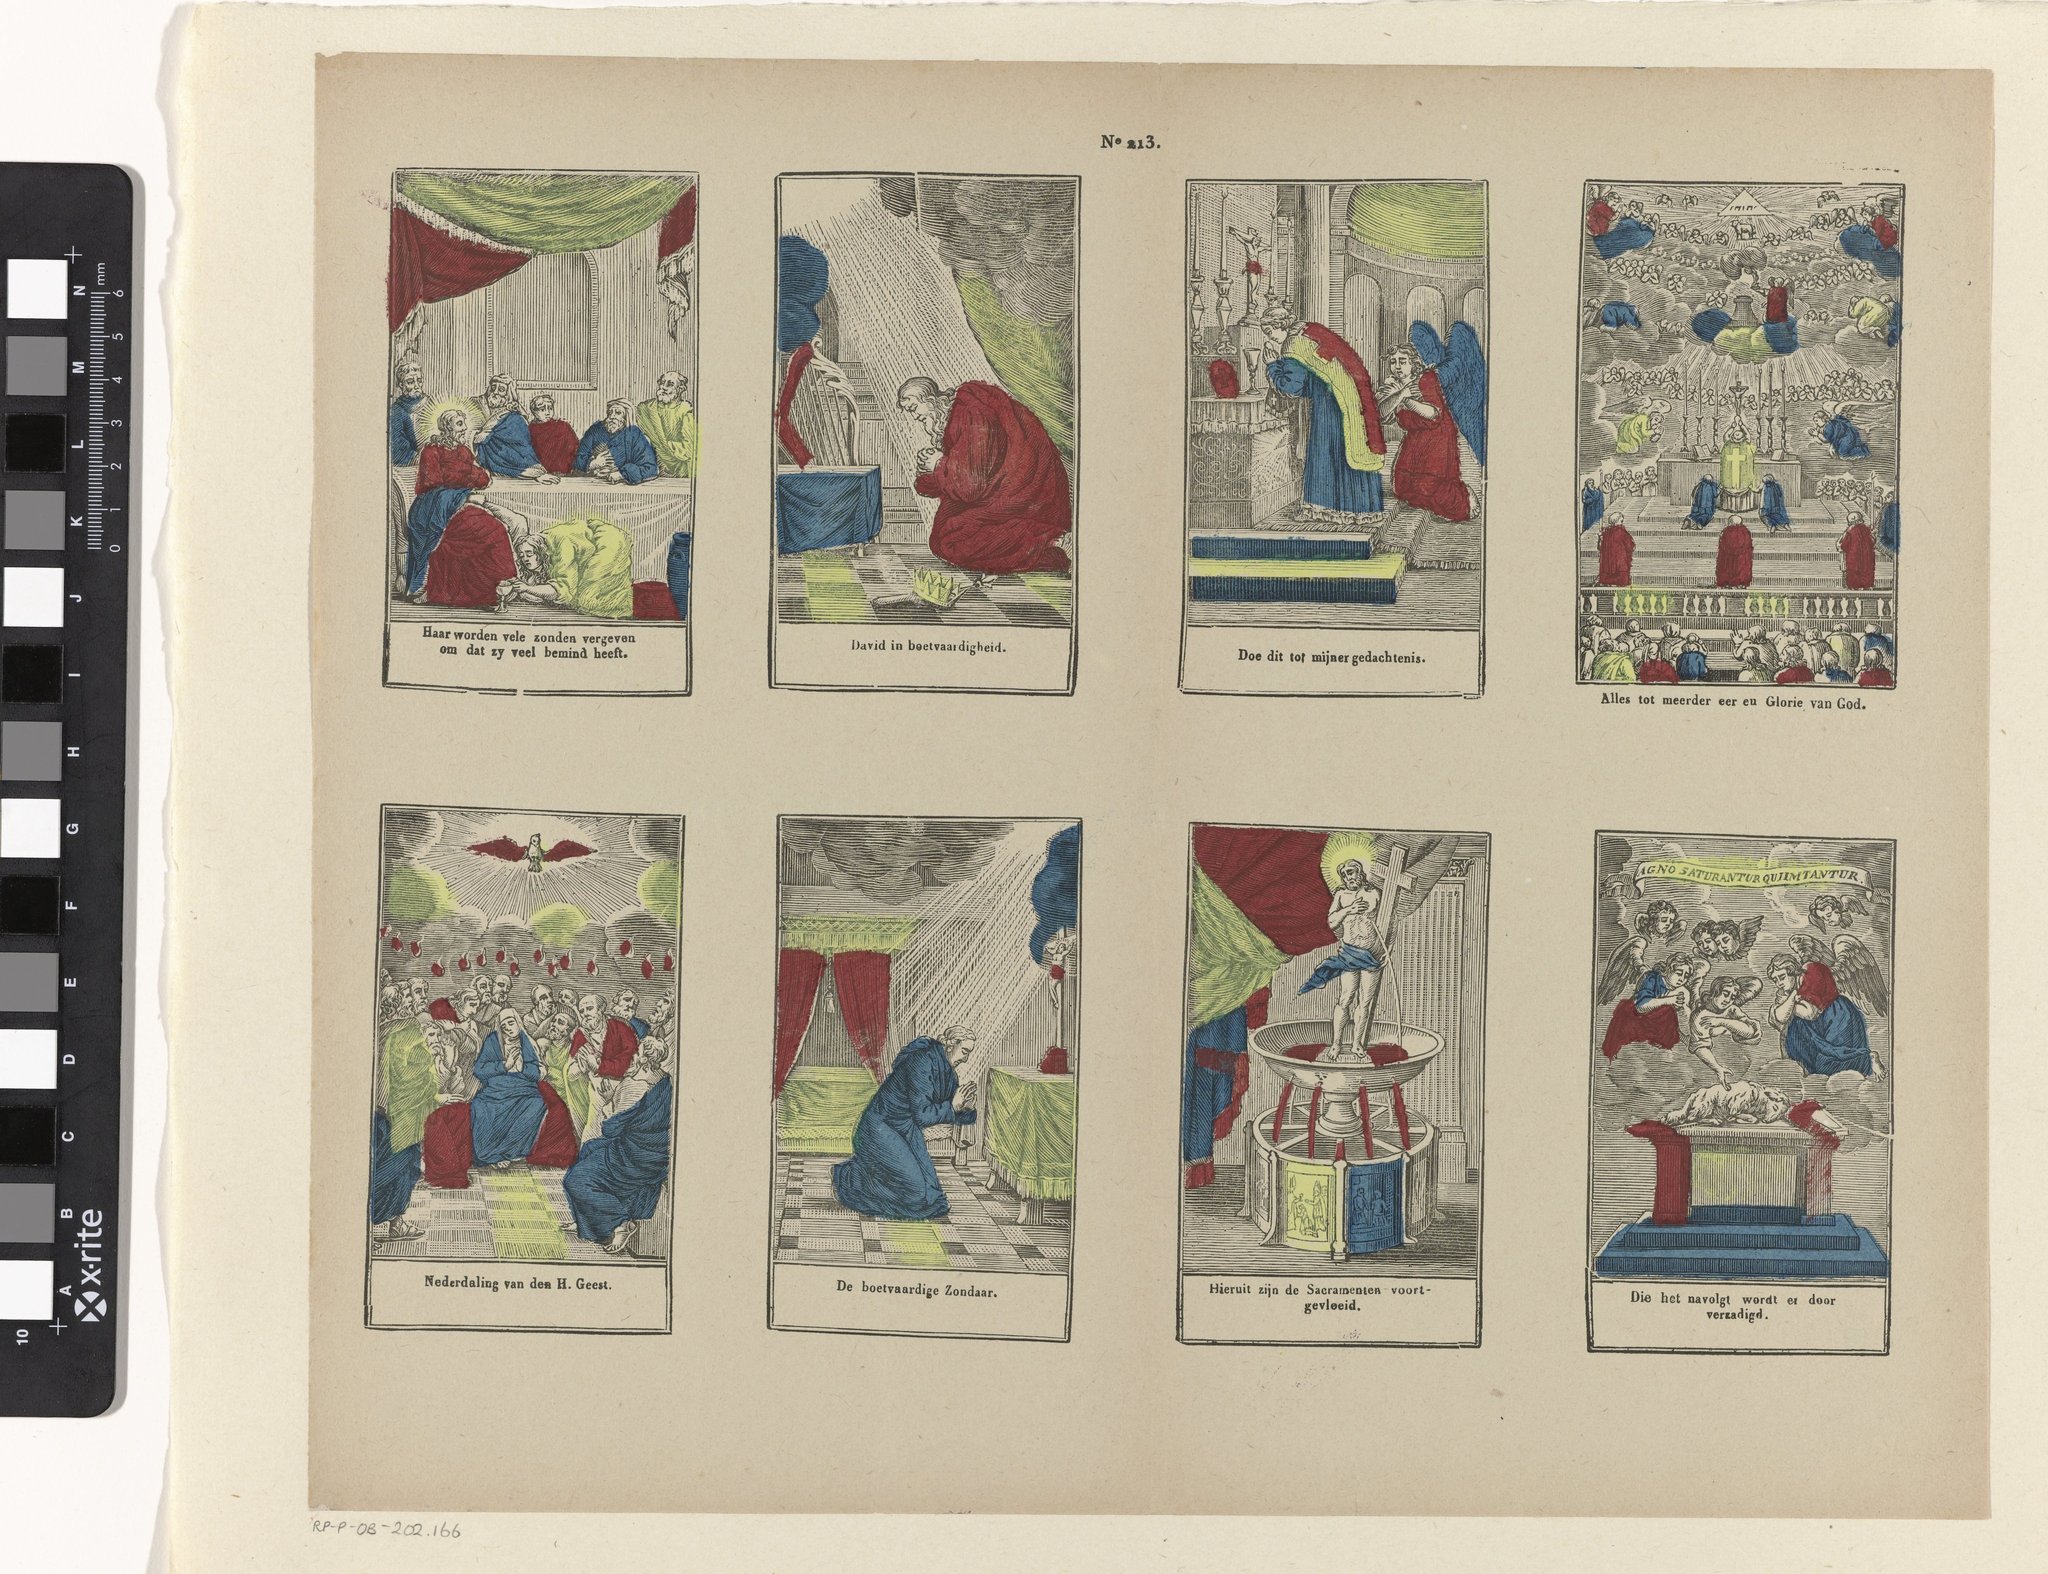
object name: popular print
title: Religieuze voorstellingen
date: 1800-1833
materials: paper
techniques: colour, letterpress printing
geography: turnhout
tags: sacrifice of the paschal lamb ~ jewish religion, david penitent, pentecost: the holy ghost descends upon (mary and) the apostles, sometimes paul and/or representatives of the nations present (acts 2:1-4)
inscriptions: collector's mark: Lugt 2760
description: Blad met 8 religieuze voorstellingen, waaronder David in gebed, de neerdaling van de Heilige Geest met pinksteren en het Lam Gods op een altaar. Onder elke voorstelling een onderschrift. Genummerd midden boven: No. 213.